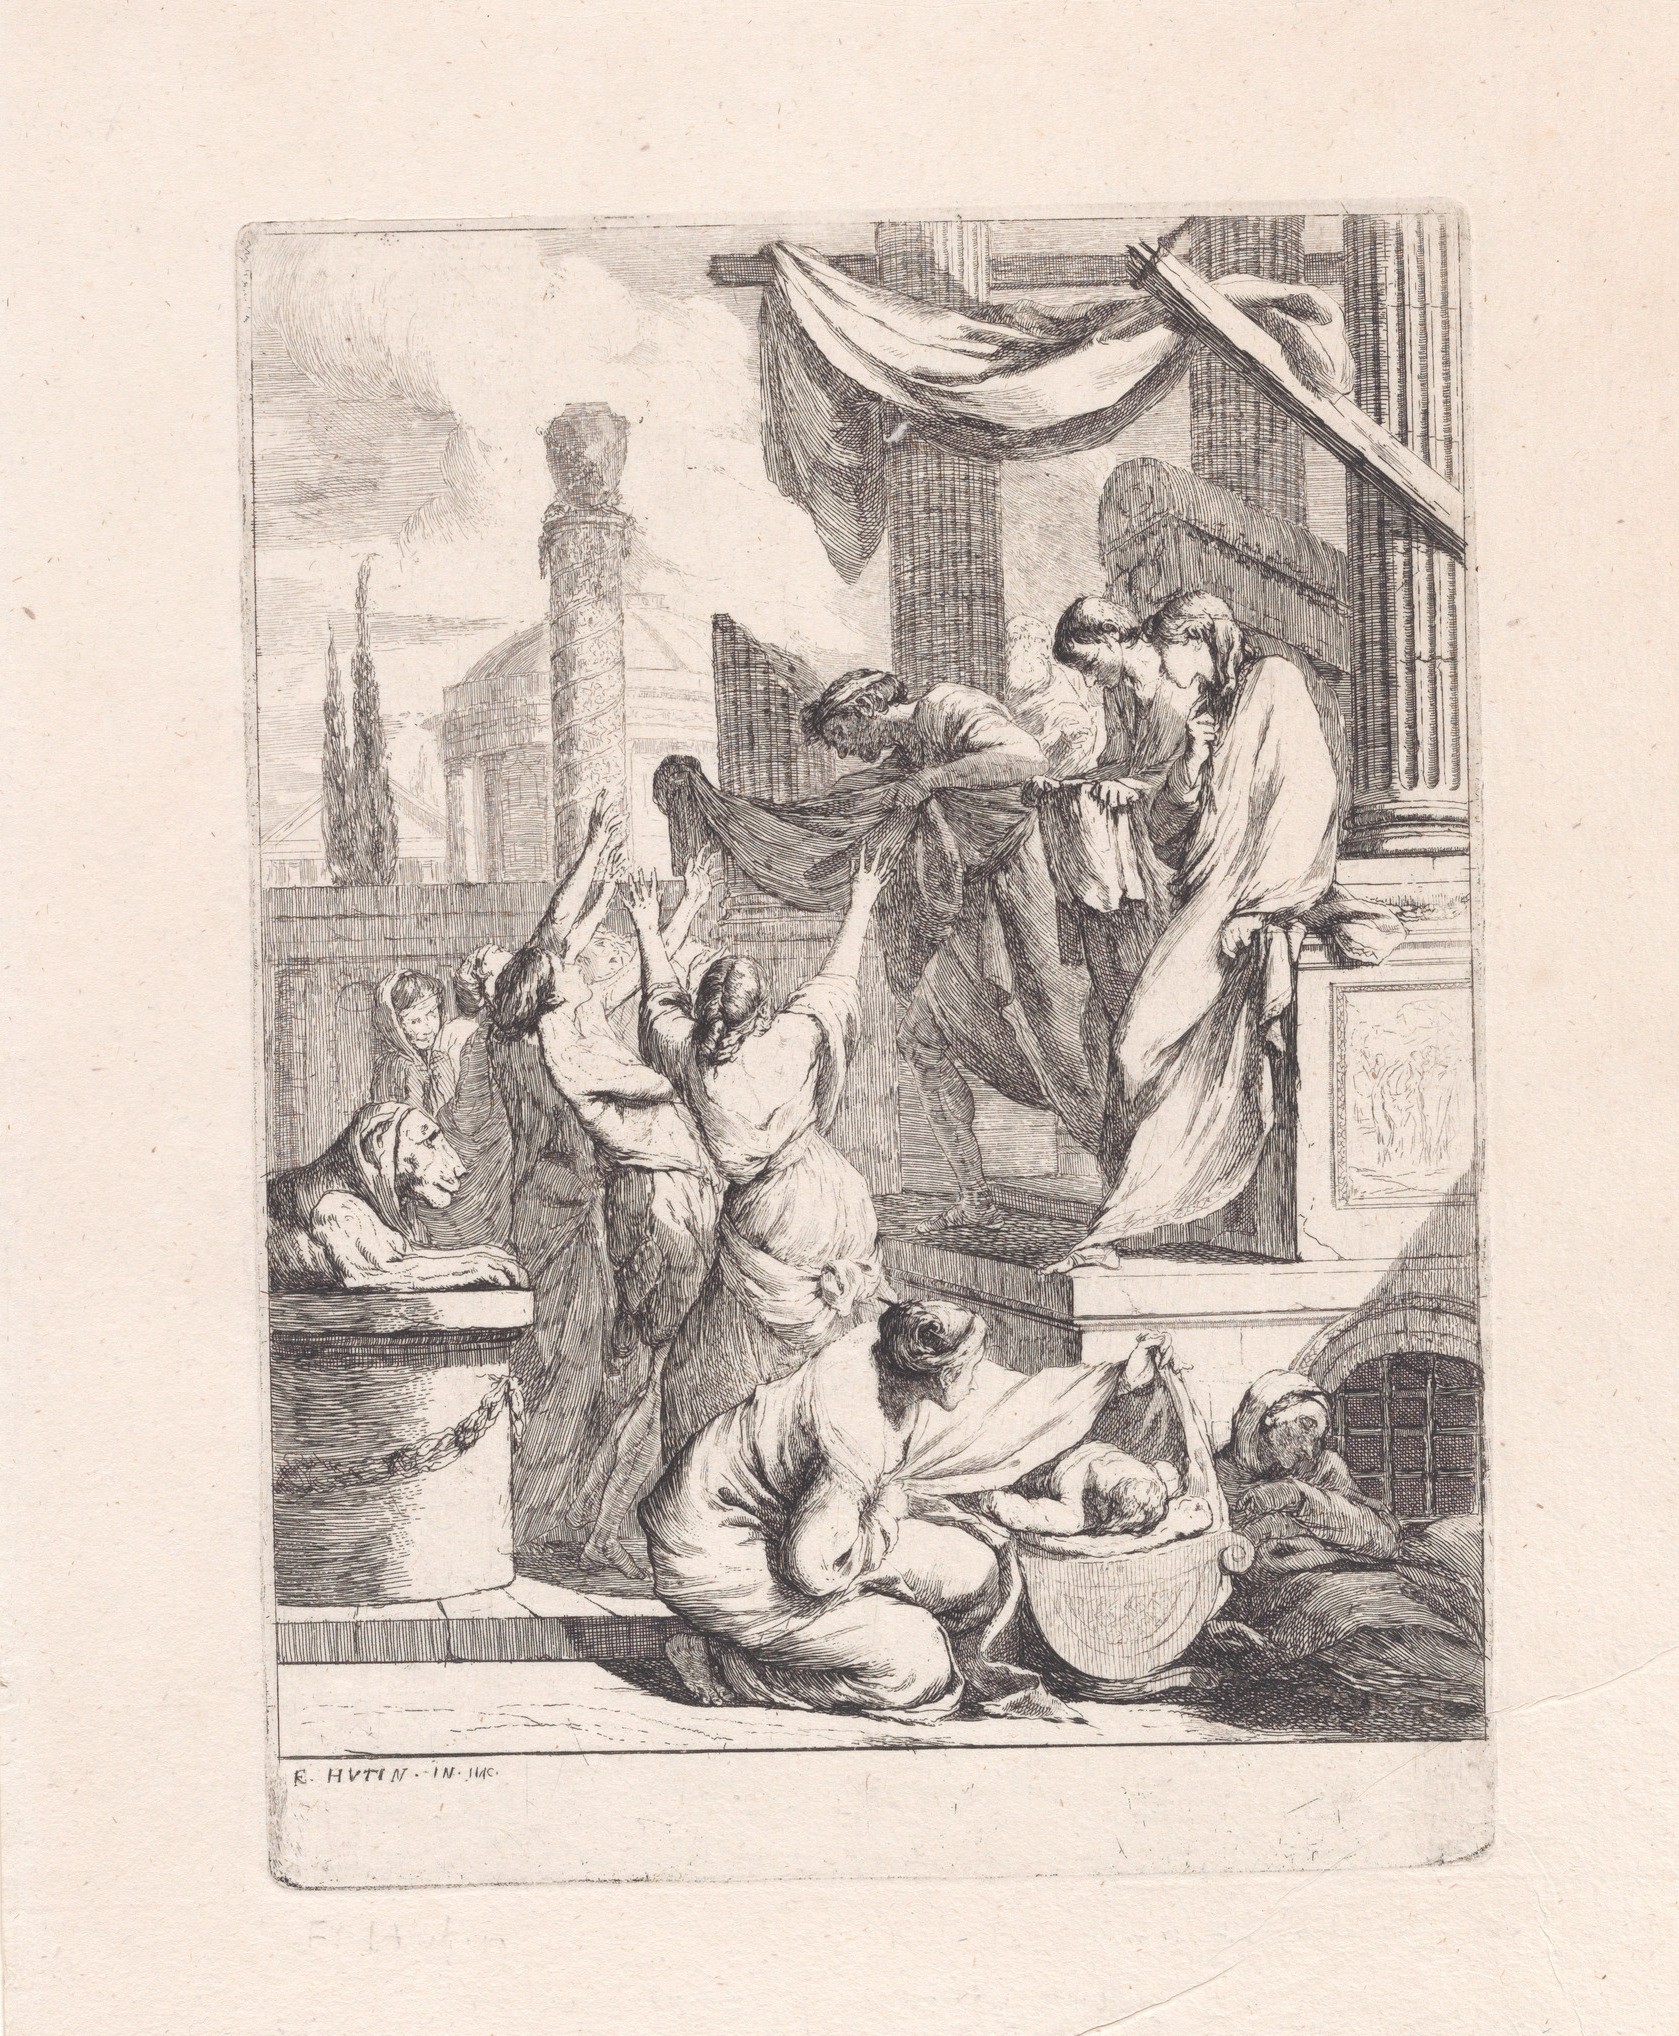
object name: print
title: Clothing the Naked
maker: françois hutin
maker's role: artist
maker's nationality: french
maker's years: 1686-1758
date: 1737-1742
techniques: etching